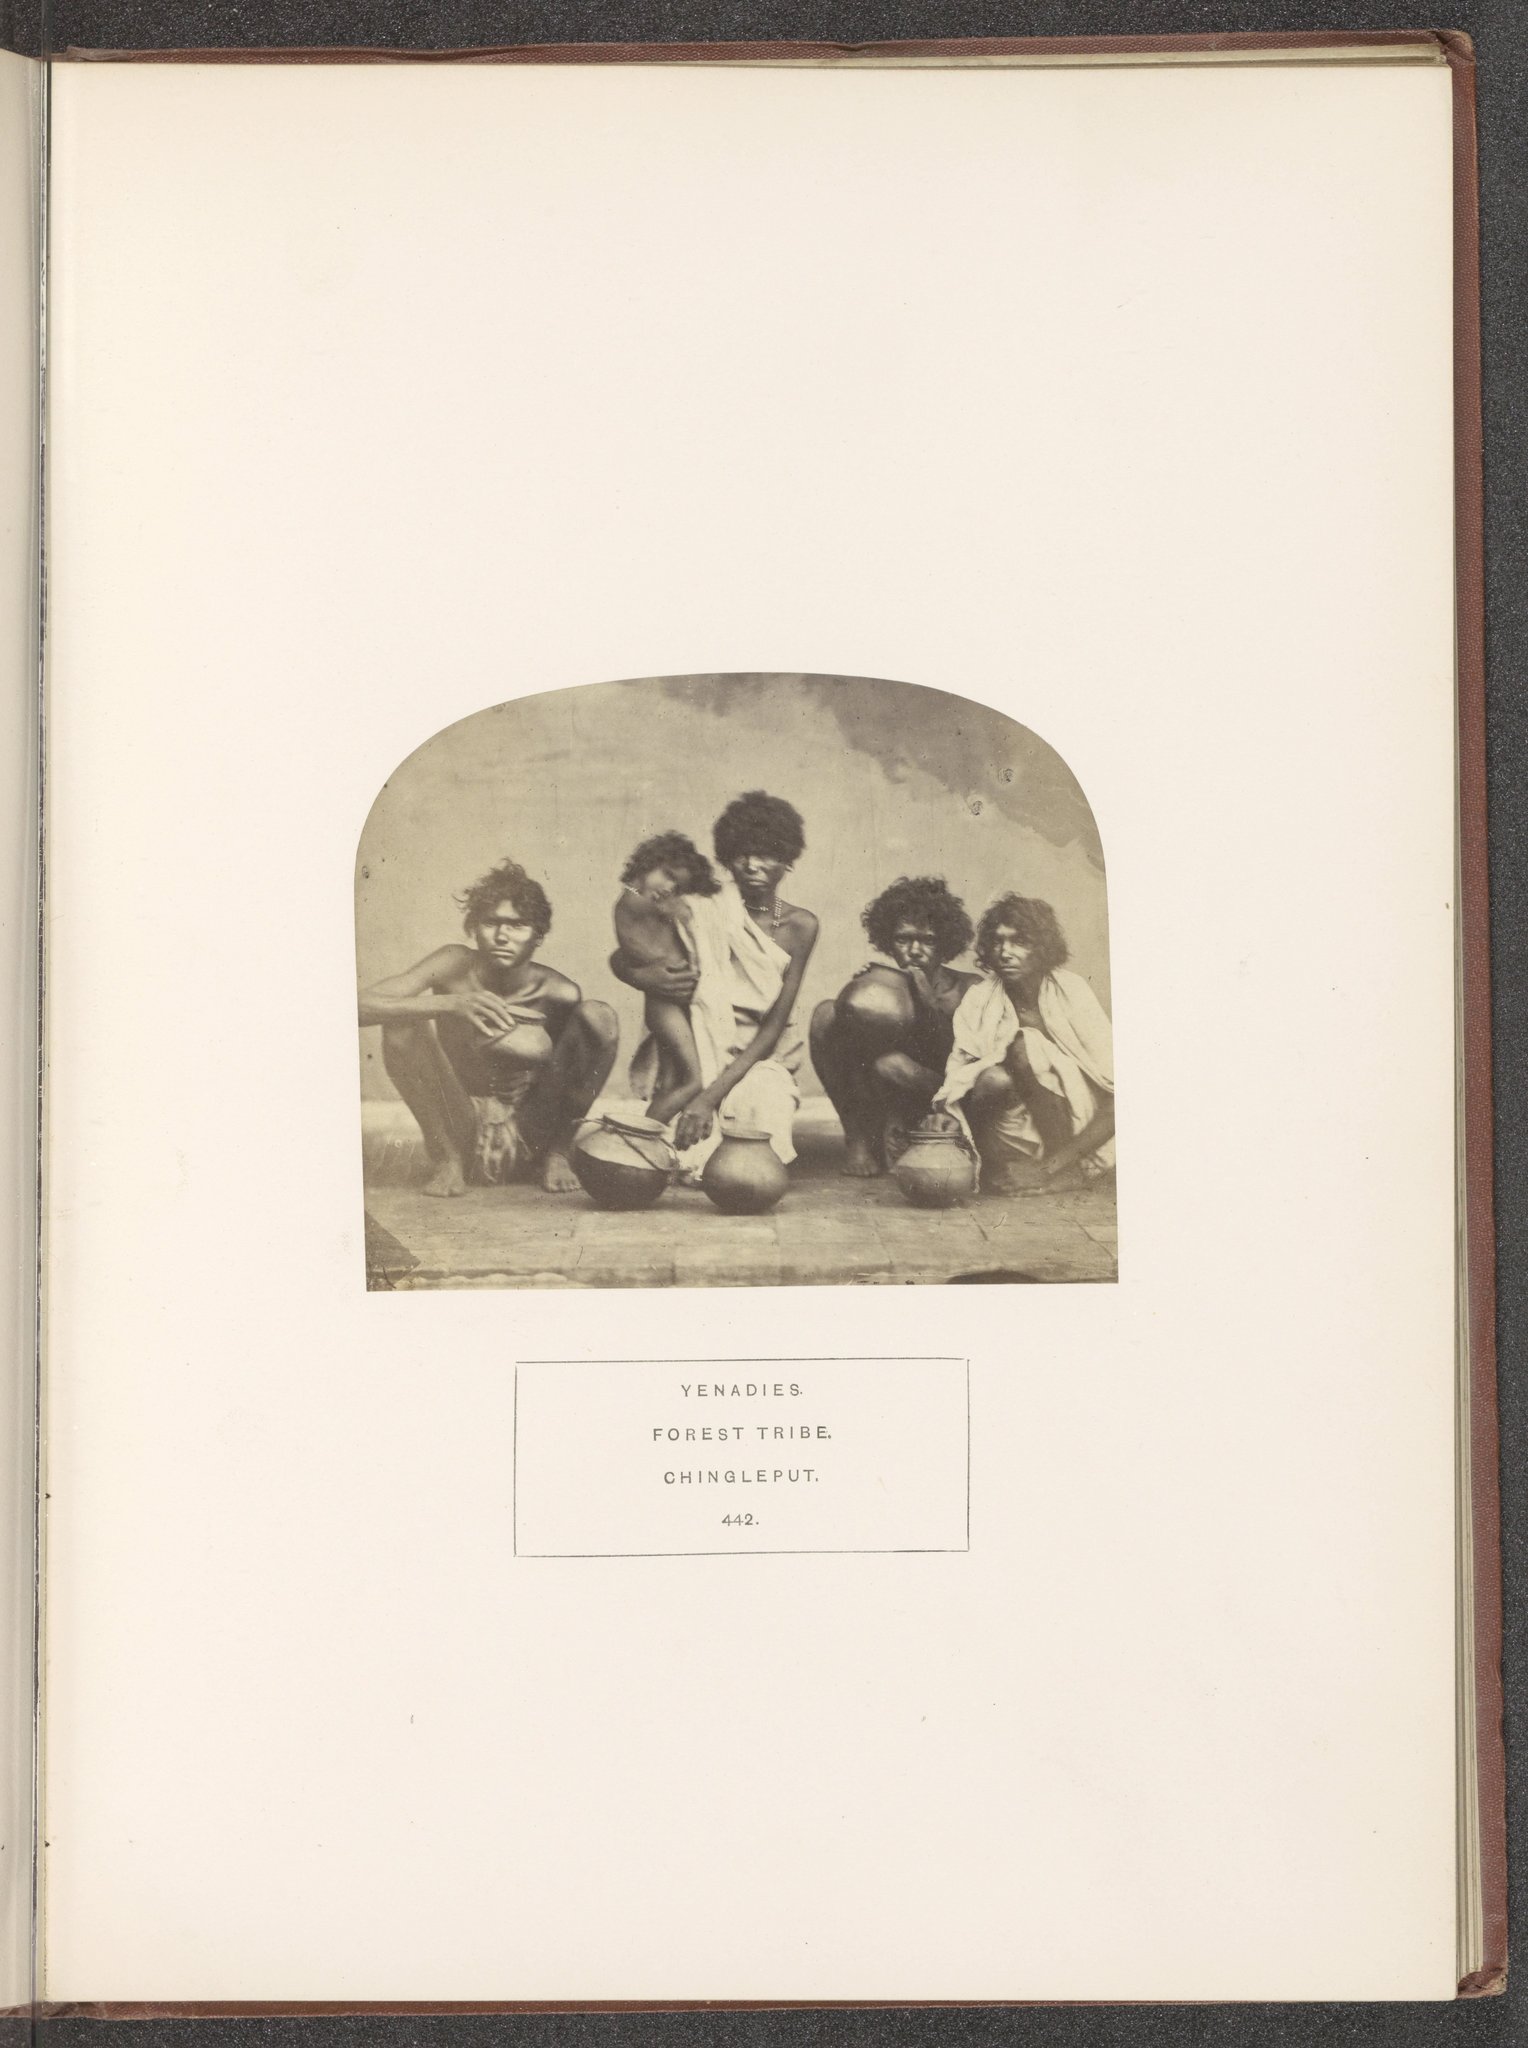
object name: page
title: Group portrait of a family from the Yenadi tribe with cooking pots, Chengalpattu, Tamil Nadu, India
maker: Anonymous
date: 1865-1875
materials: photographic support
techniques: albumen print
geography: chengalpattu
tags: kitchen-utensils: pot, human races; peoples; nationalities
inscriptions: inscription: ‘YENADIES./ FOREST TRIBE./ CHINGLEPUT.’, number: ‘442.’